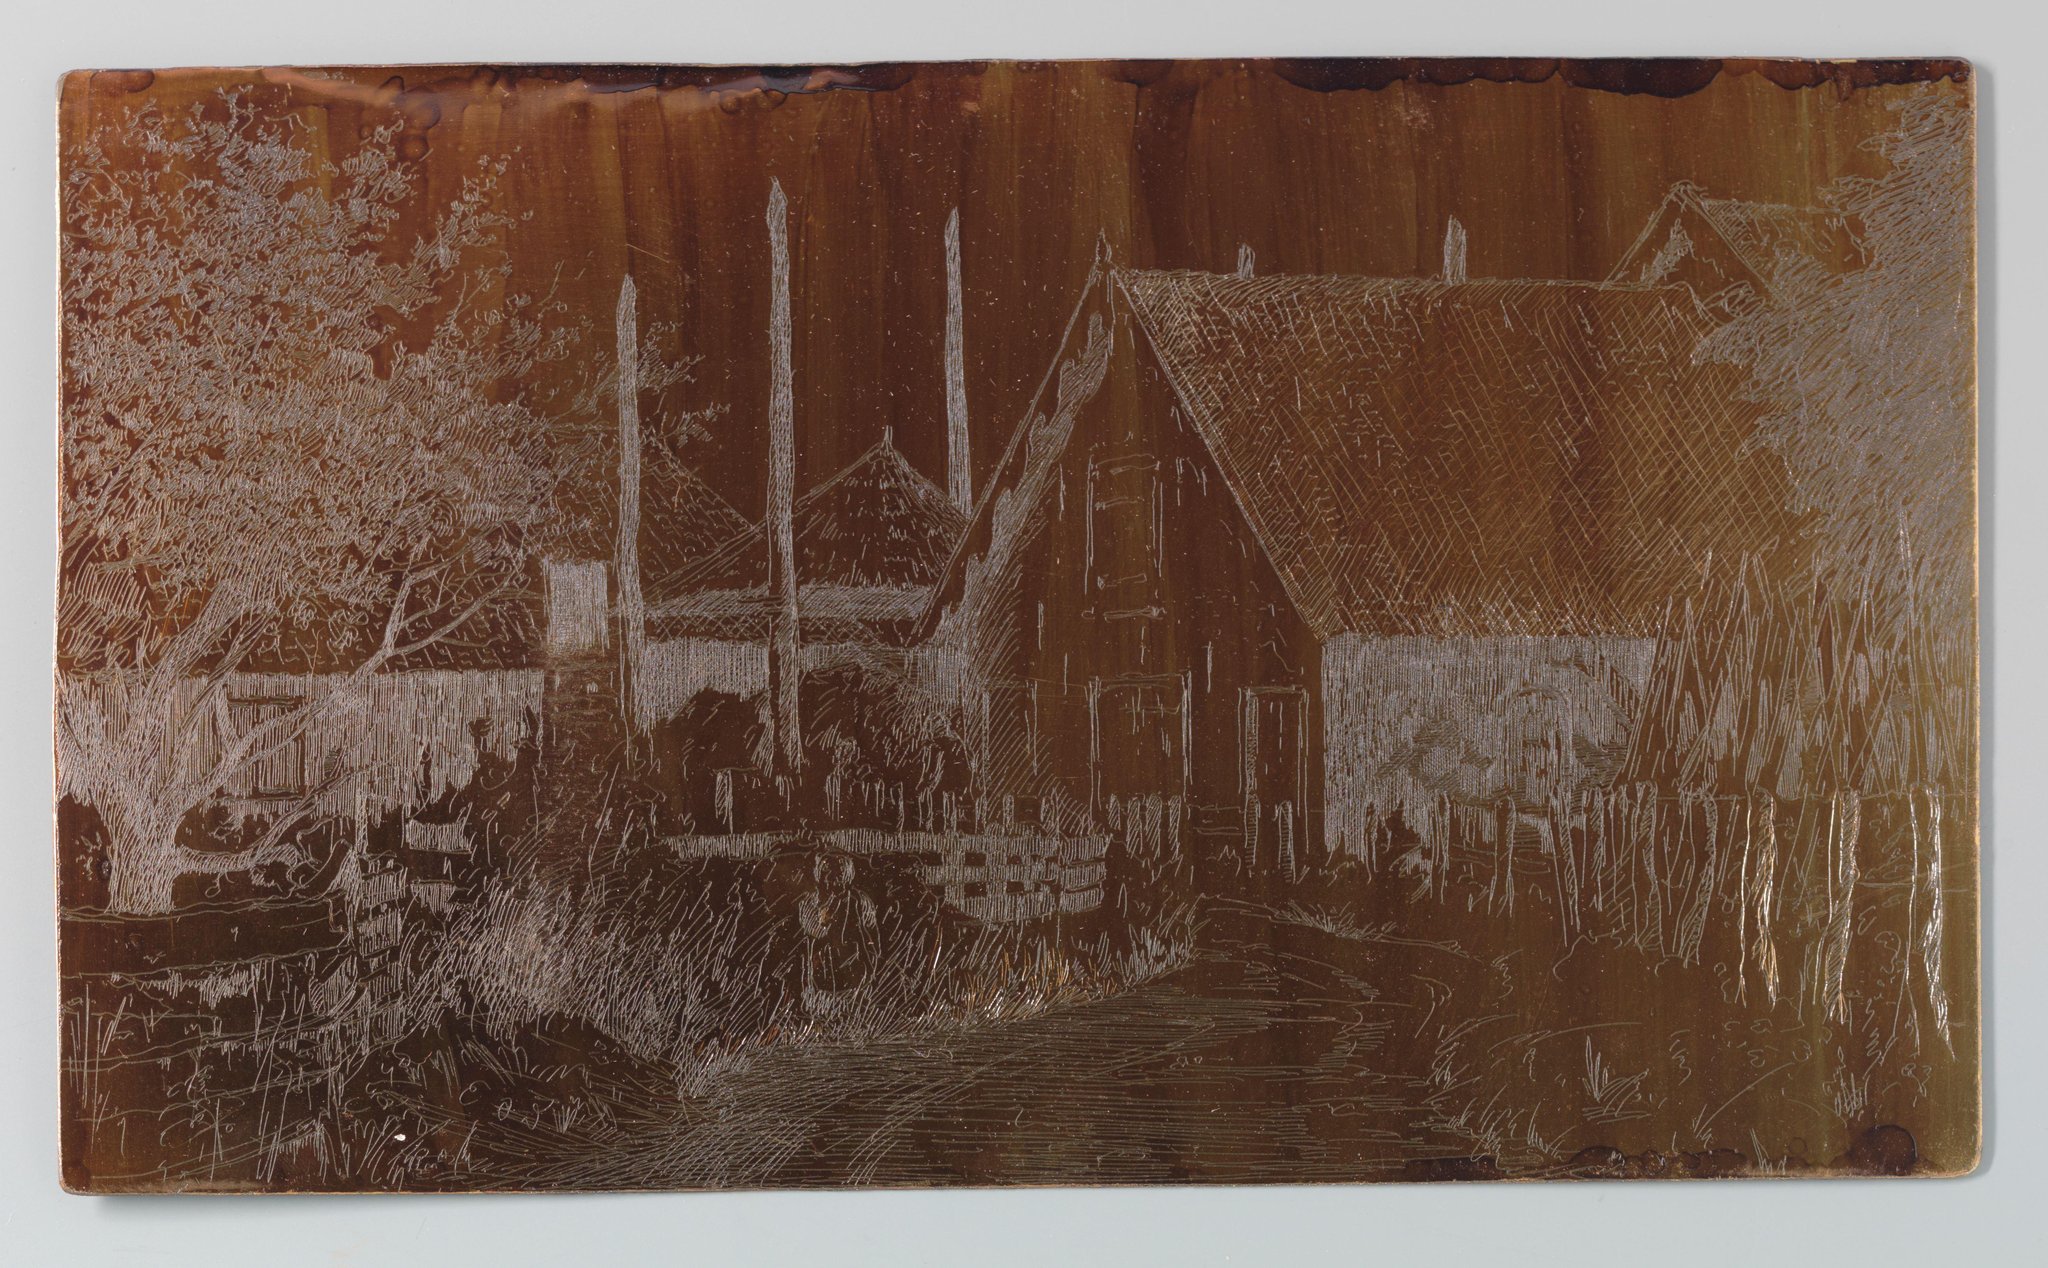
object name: copper plate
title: Boerderij met hooischuur, bij Voorburg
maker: willem adrianus grondhout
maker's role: draughtsman, painter, print maker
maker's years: 1878-1934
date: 1888-1934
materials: copper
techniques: etching